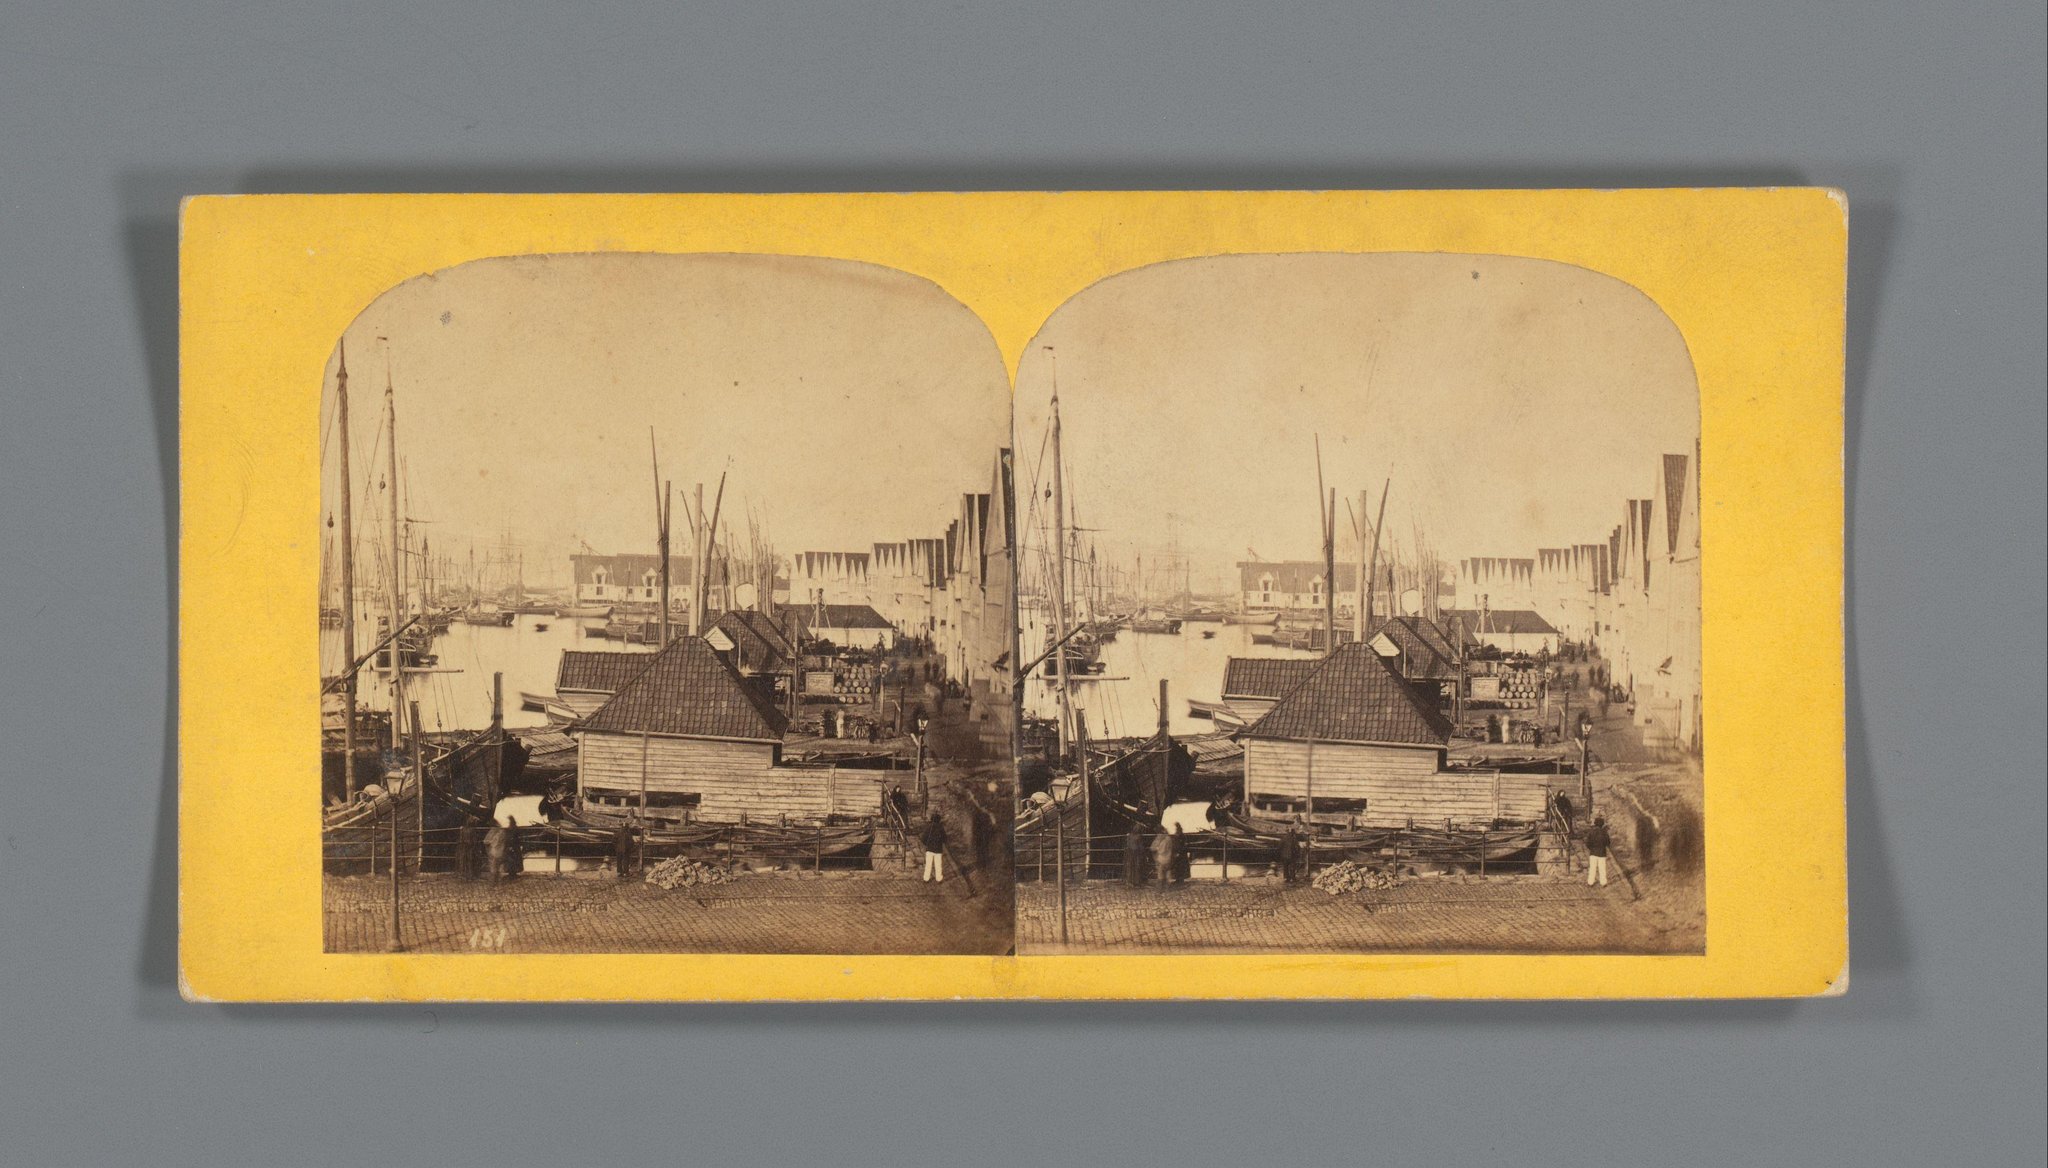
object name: stereograph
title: Gezicht op Bryggen in Bergen, Noorwegen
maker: marcus selmer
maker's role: fotograaf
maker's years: 1819-1900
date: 1861-1870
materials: cardboard, paper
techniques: albumen print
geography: bergen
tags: harbour, quay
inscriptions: number: ‘151’, number: ‘151’